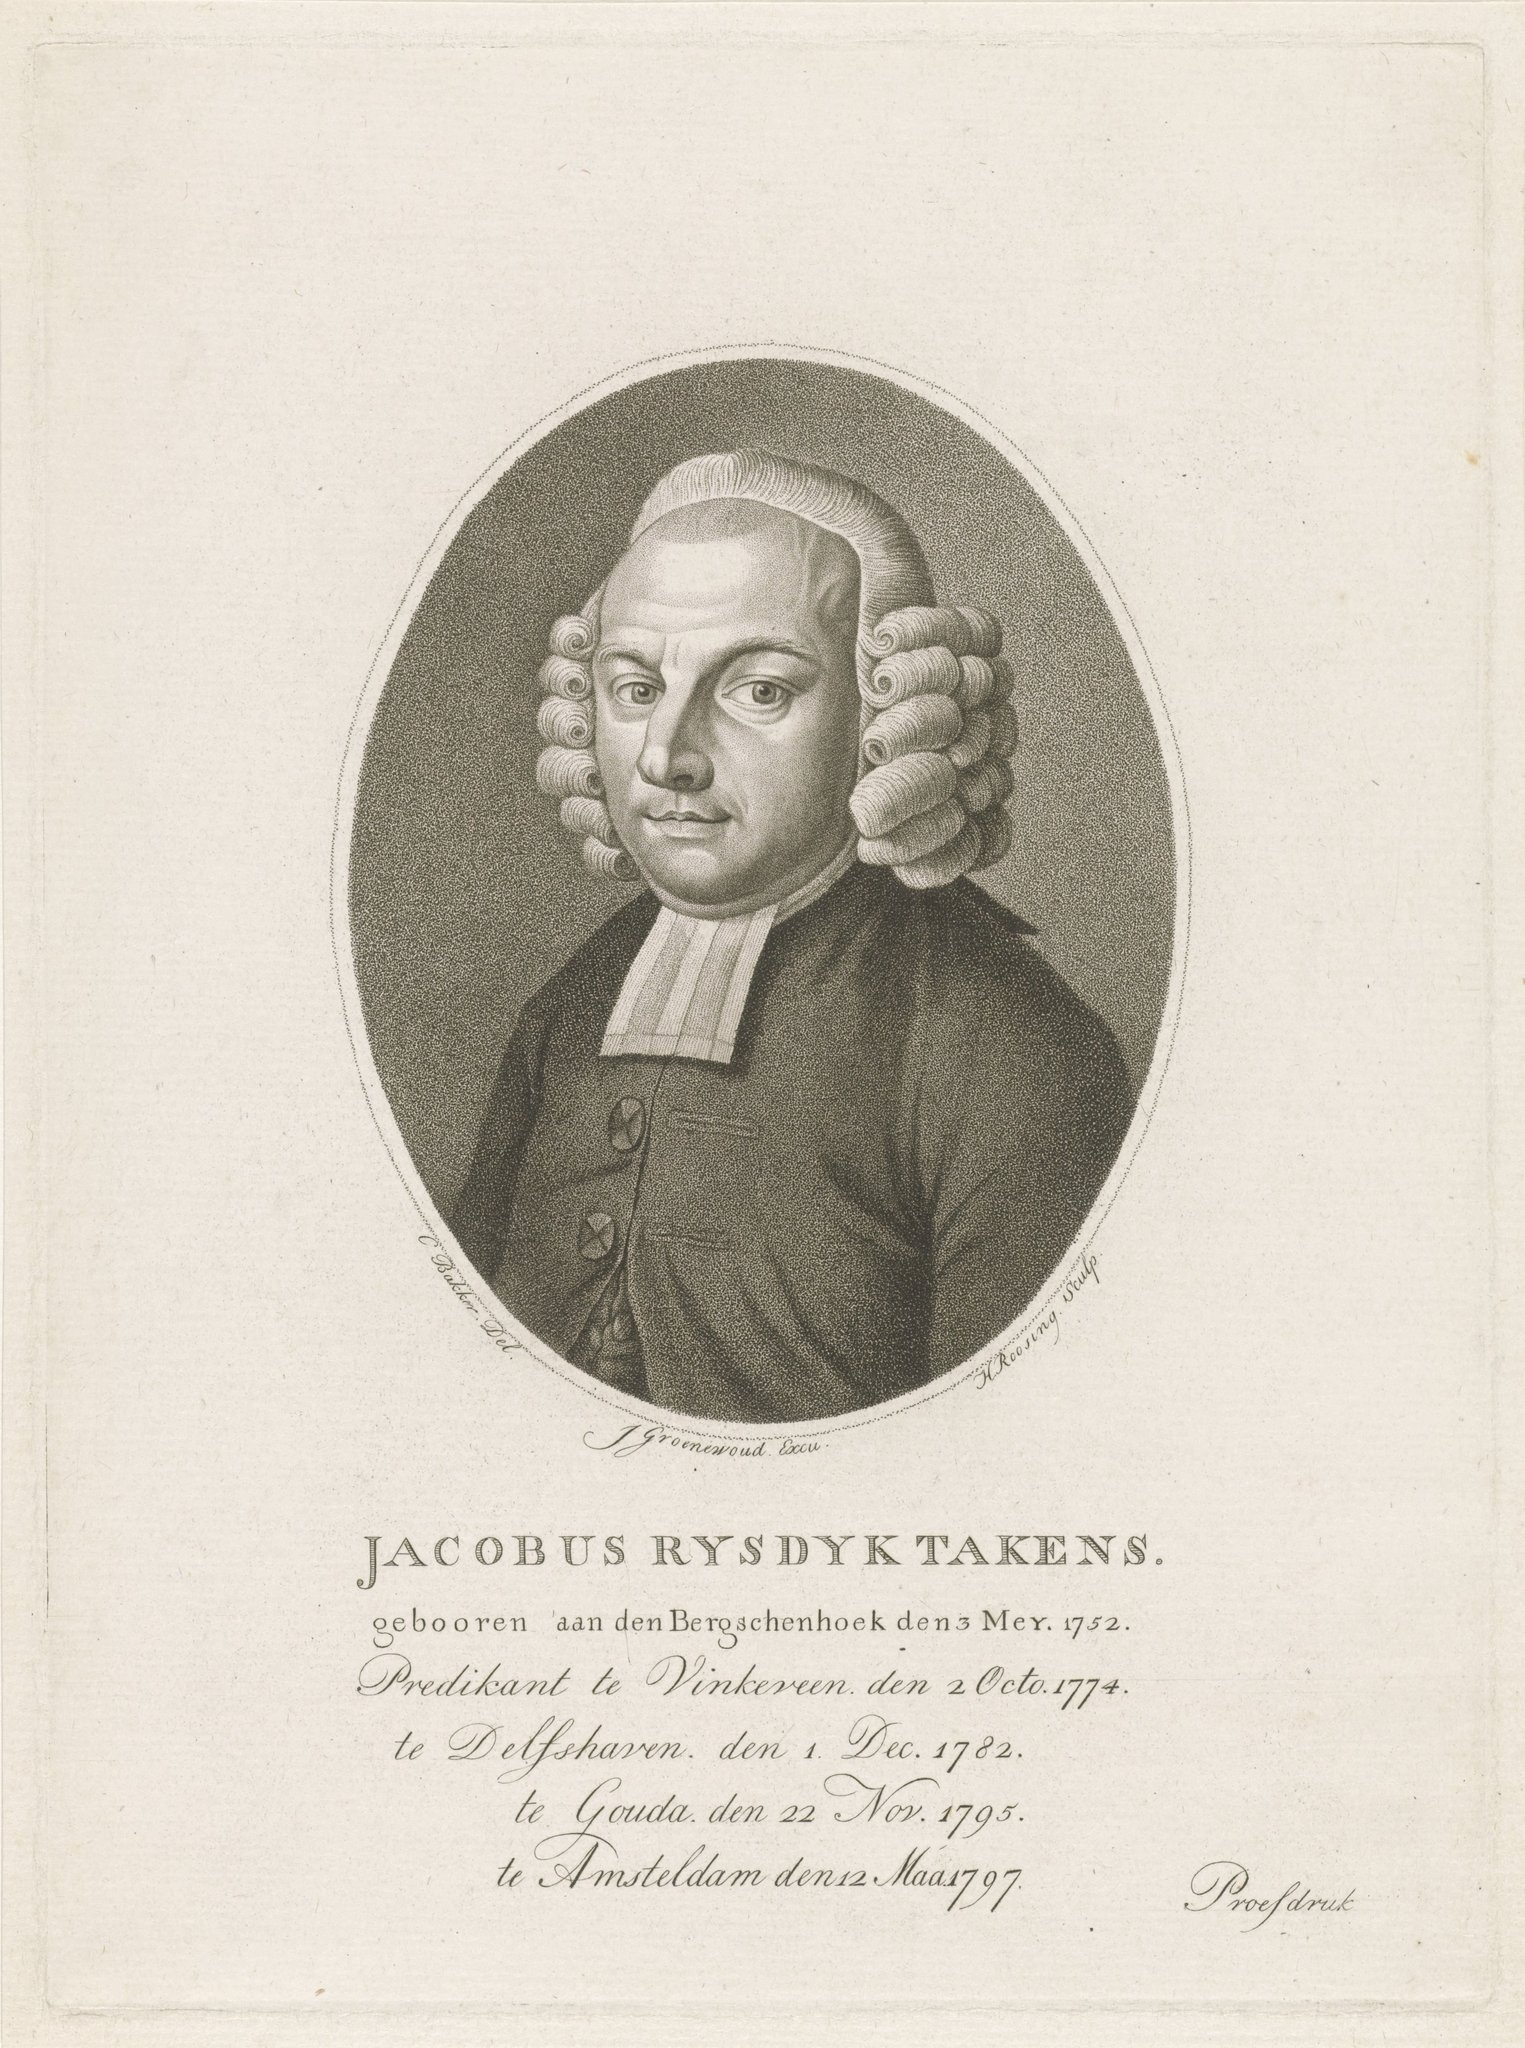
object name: print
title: Portret van de predikant Jacobus Rijsdijk Takens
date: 1797-1826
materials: paper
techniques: engraving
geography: rotterdam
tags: bergschenhoek, predikant, jacobus rijsdijk takens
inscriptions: collector's mark: Lugt 2228